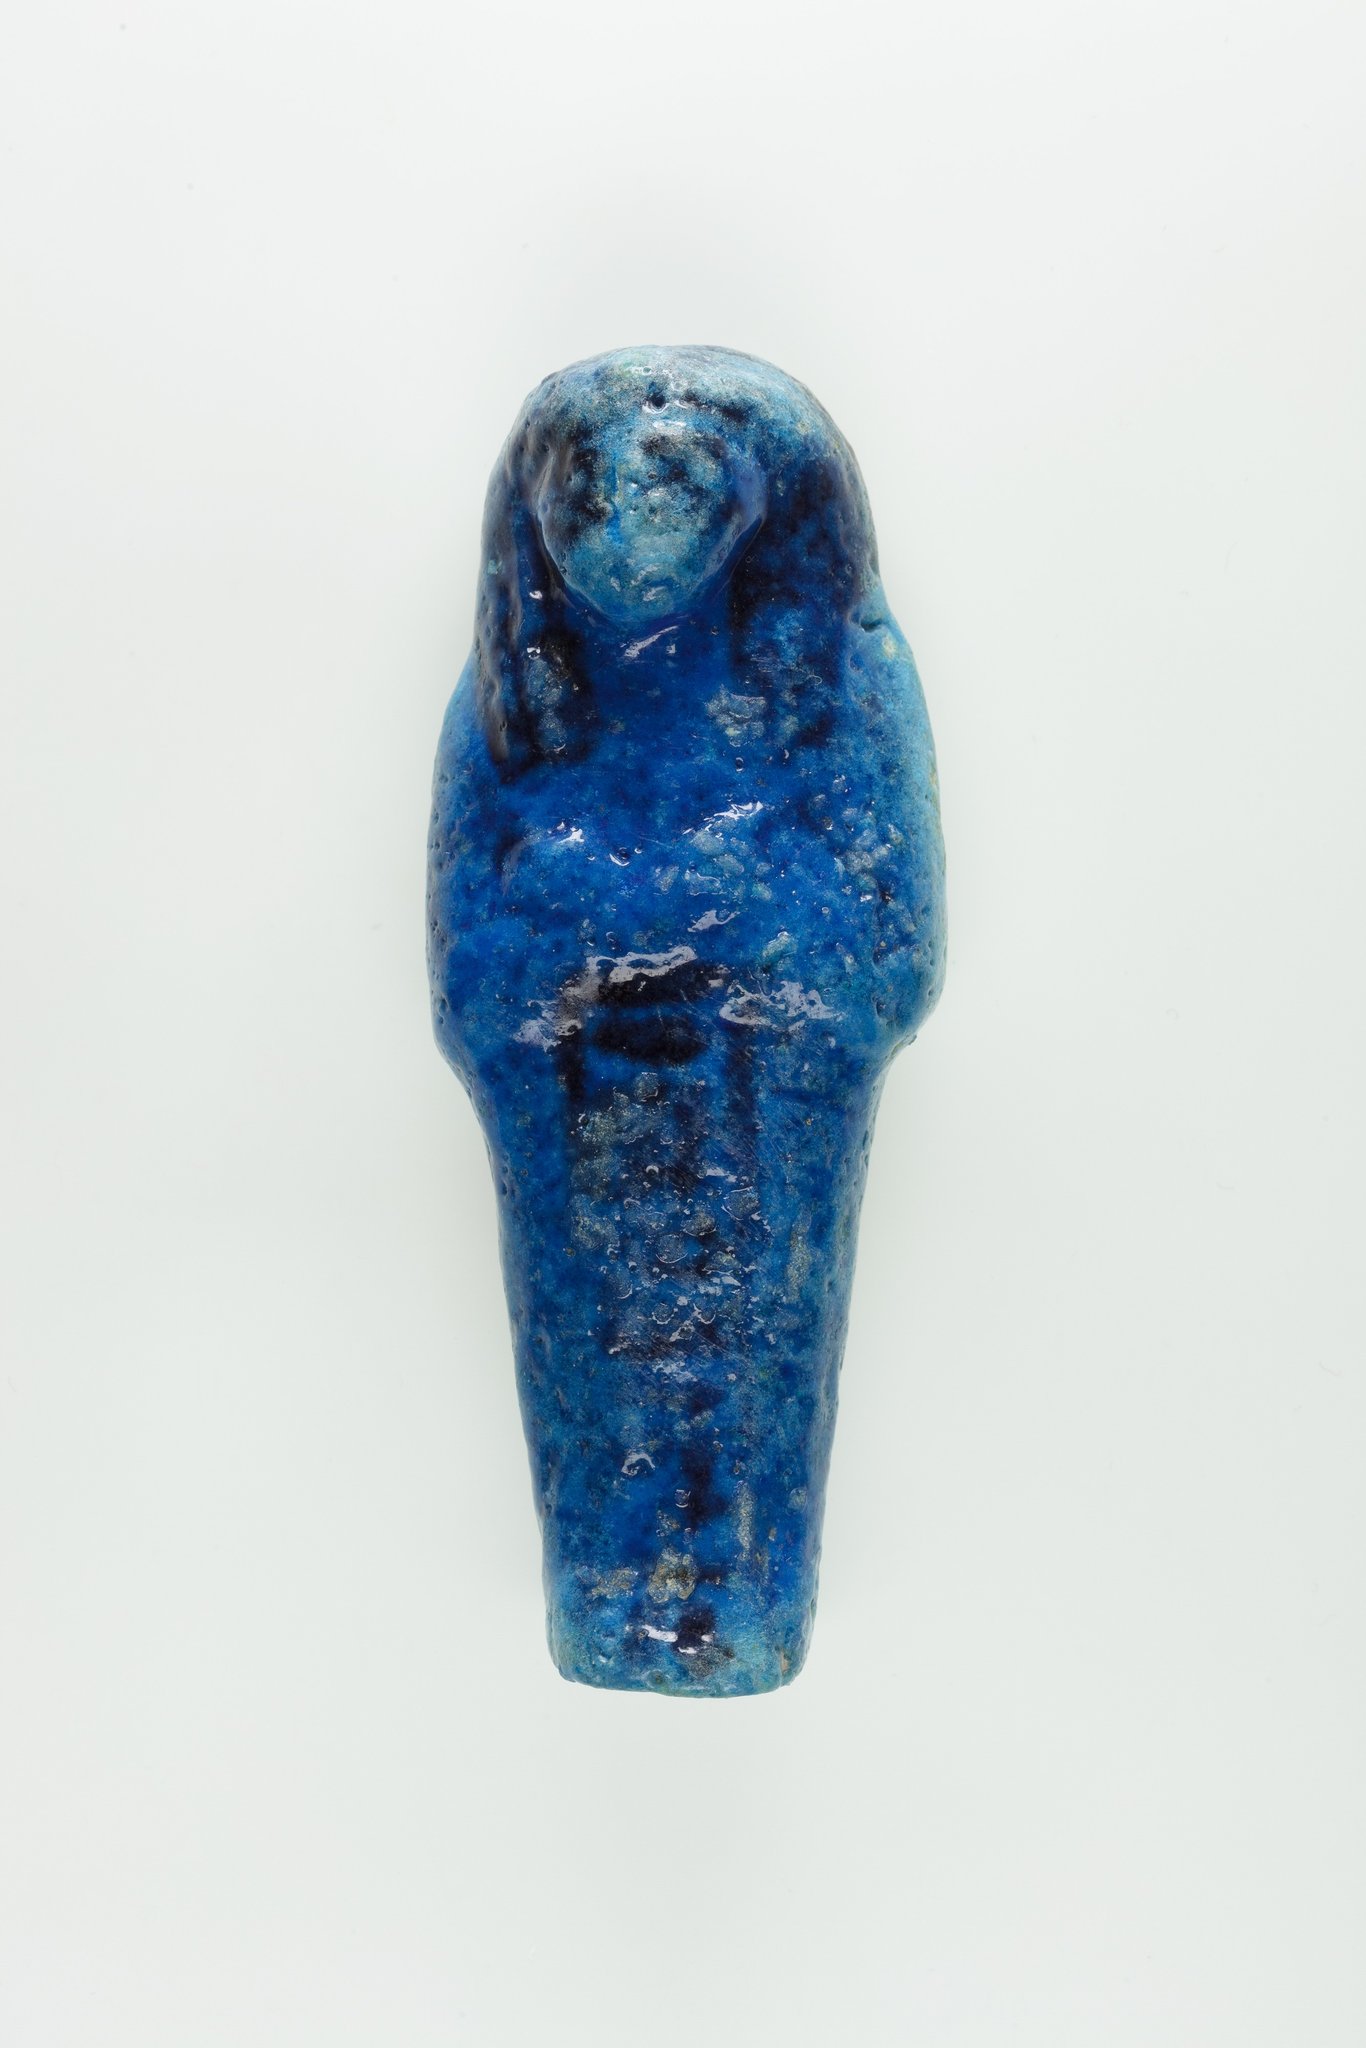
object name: shabti, worker, nauny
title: Worker Shabti of Nauny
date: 1050 BCE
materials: faience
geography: egypt